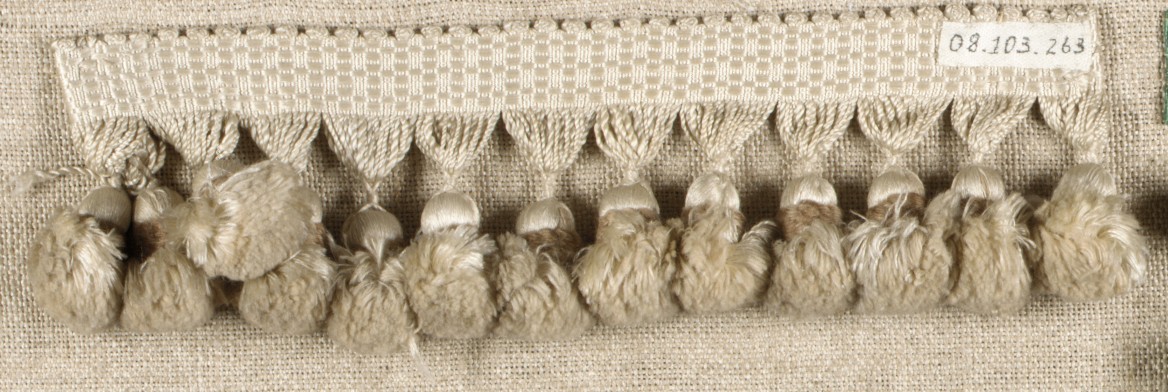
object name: fringe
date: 1801-1900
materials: silk